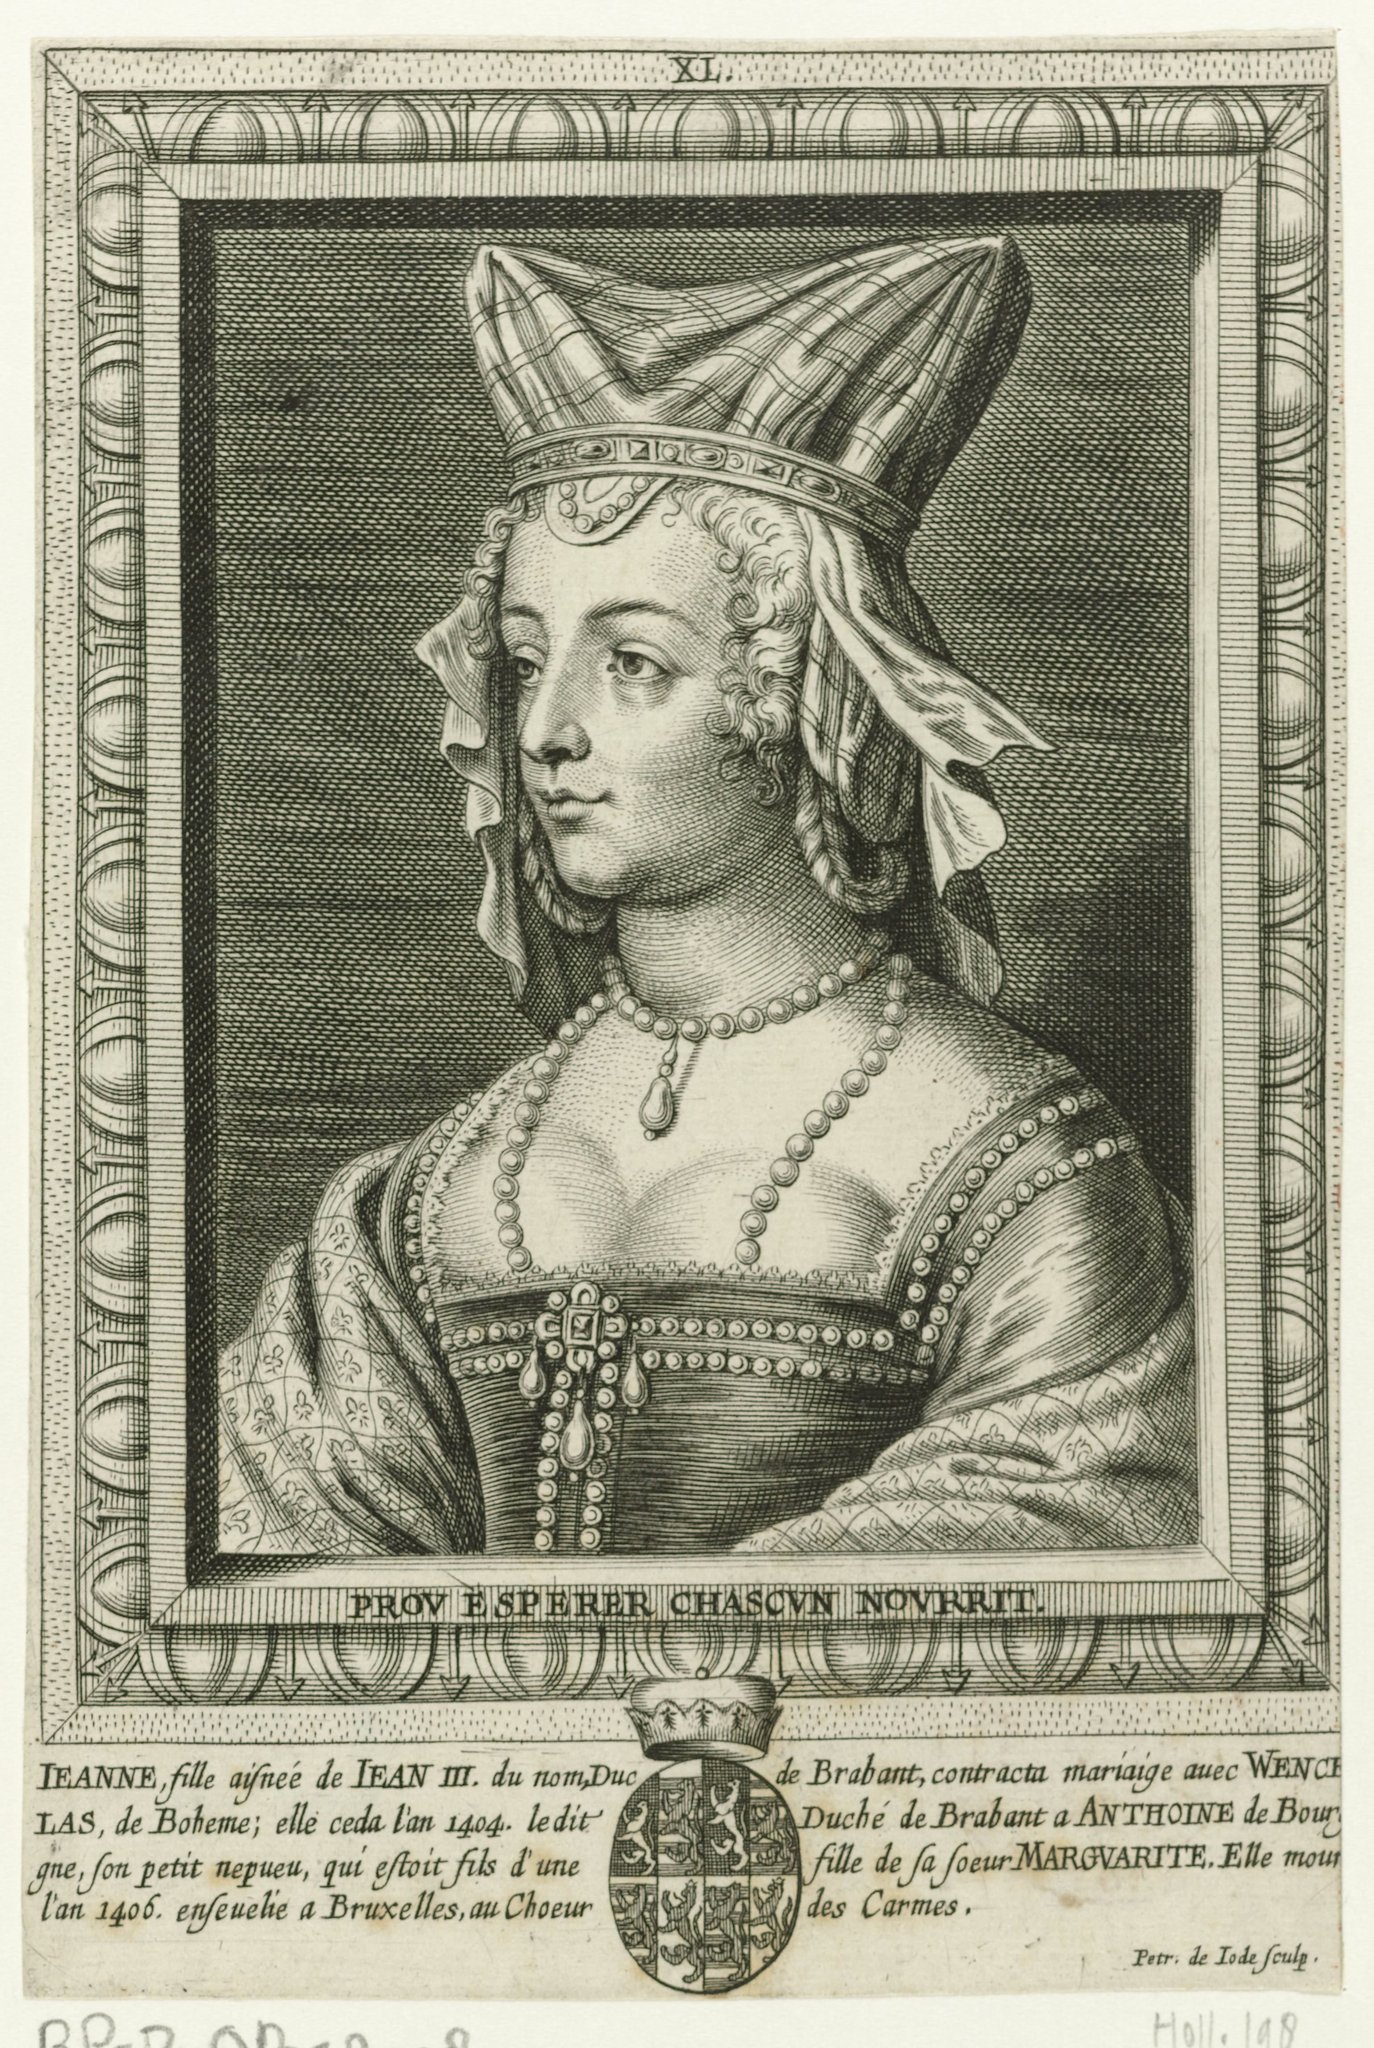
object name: book illustration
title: Portret van Johanna van Brabant, gemalin van Wencelaus I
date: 1661-1663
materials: paper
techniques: engraving, etching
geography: antwerp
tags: brussels, head-gear (with name) (+ women's clothes)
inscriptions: collector's mark: Lugt 240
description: Busteportret van Johanna van Brabant, met hoornmuts of escoffion. Ze draagt een rijk versierde jurk met laag uitgesneden decolleté. Het portret is gevat in een rechthoekige omlijsting met een motto in het Latijn. In de marge het wapenschild van de geportretteerde en een vierregelig onderschrift in het Frans. Prent uit een boek waarin 54 prenten met portretten.